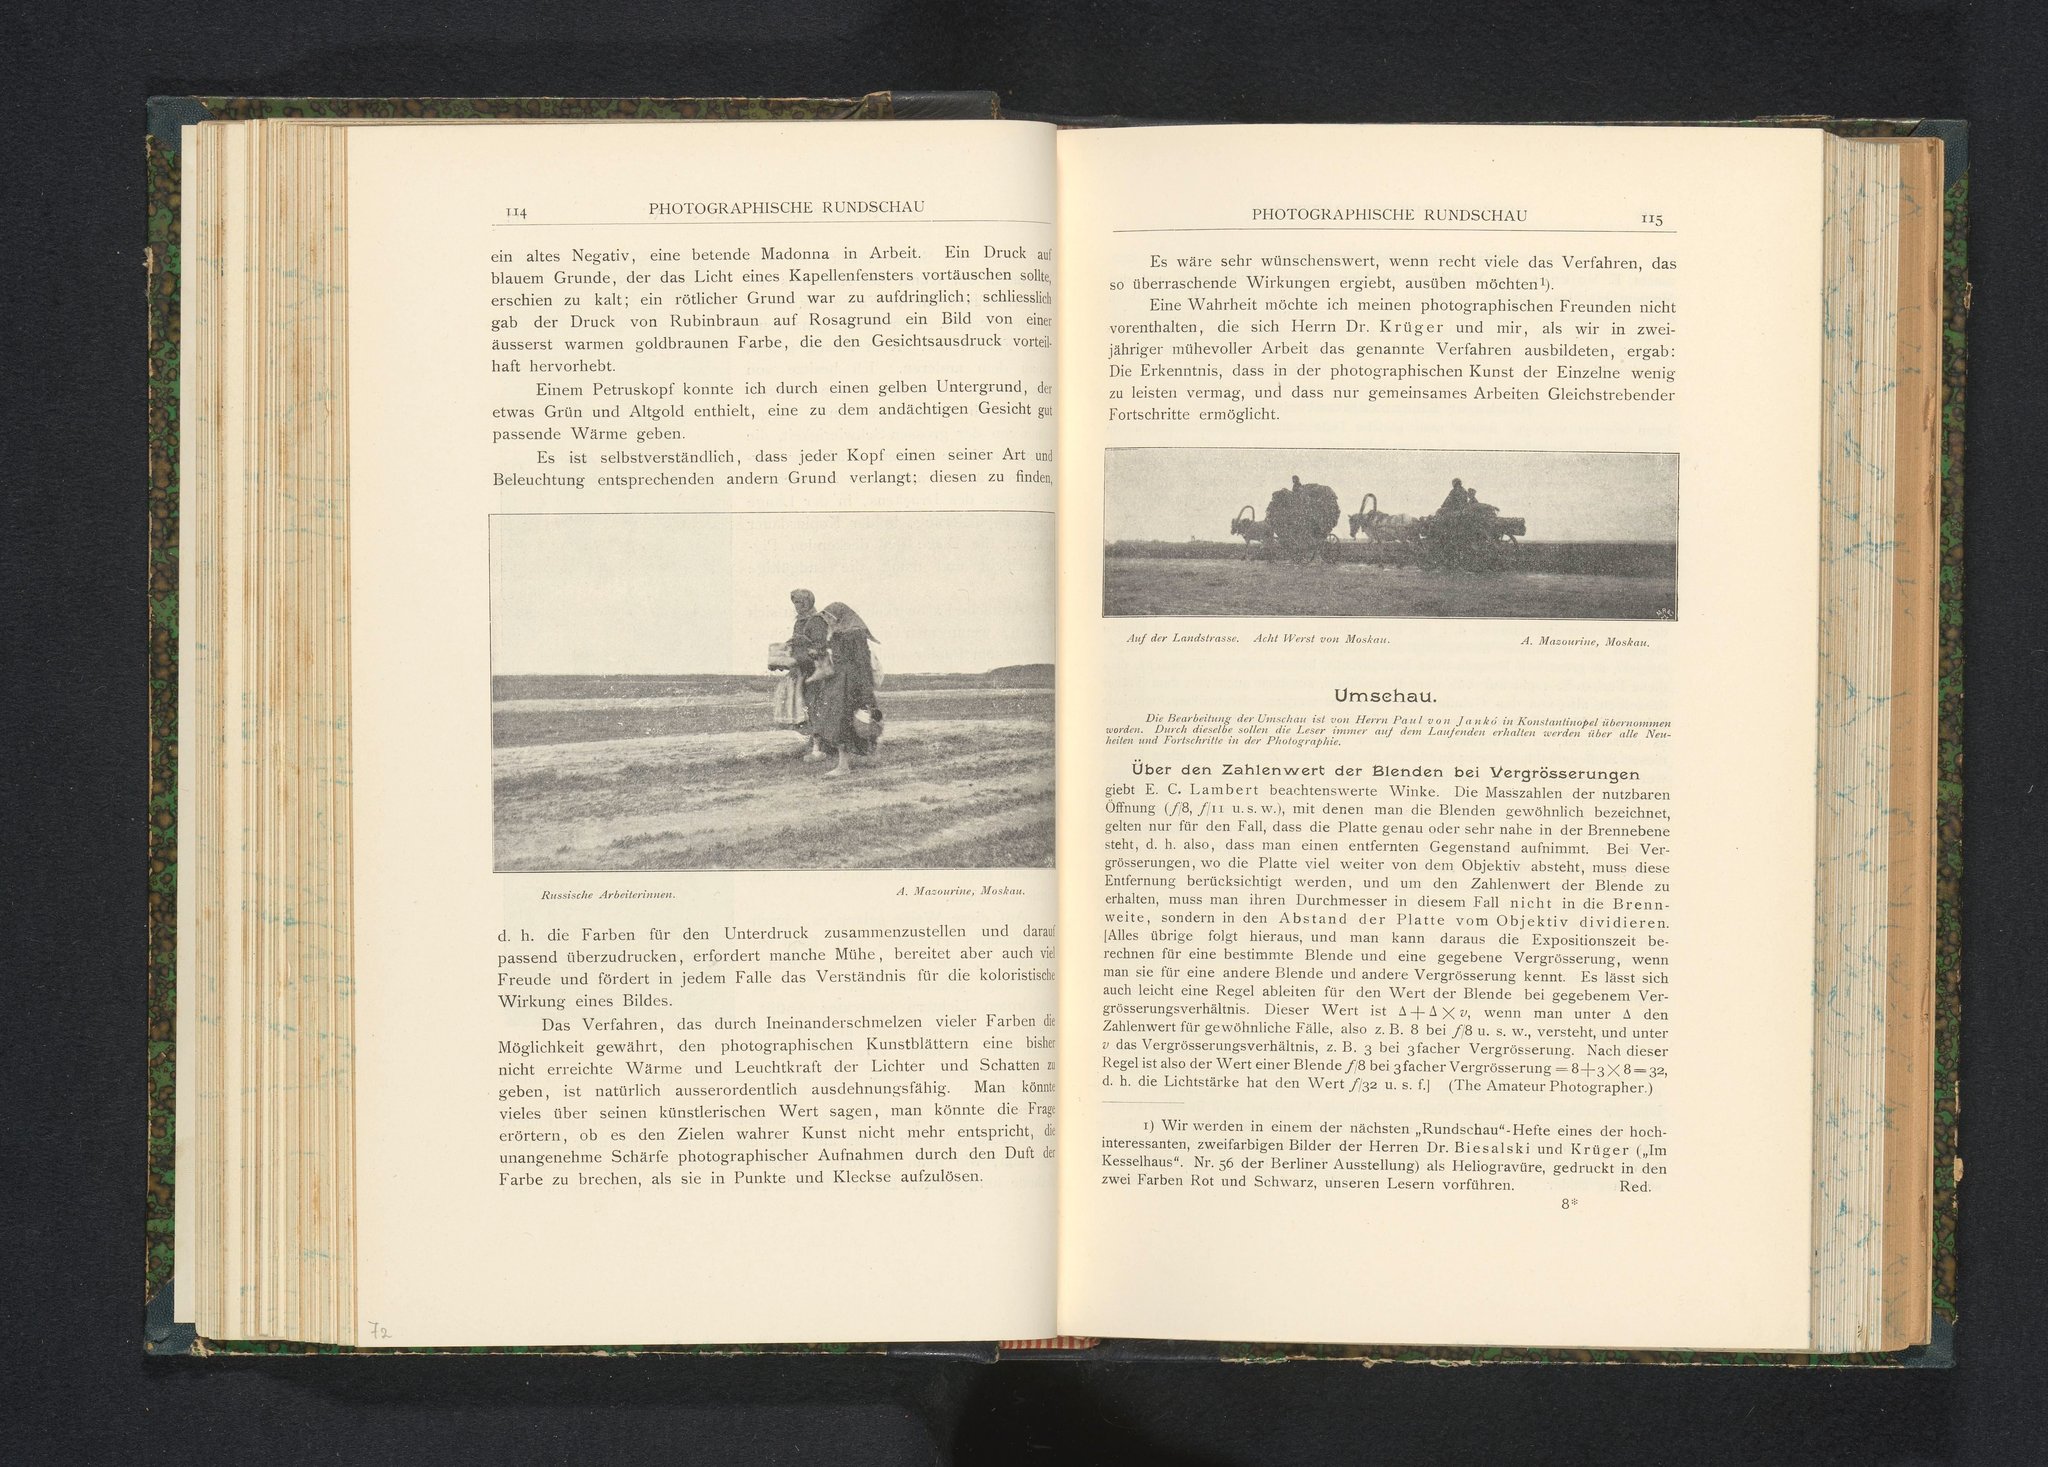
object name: page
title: Tweetal Russische vrouwen werken op het land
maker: alexis mazourine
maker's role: fotograaf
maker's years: 1846-1918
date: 1894-1899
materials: paper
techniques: autotype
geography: berlin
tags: cultivation ~ agriculture (+ women (labourers))